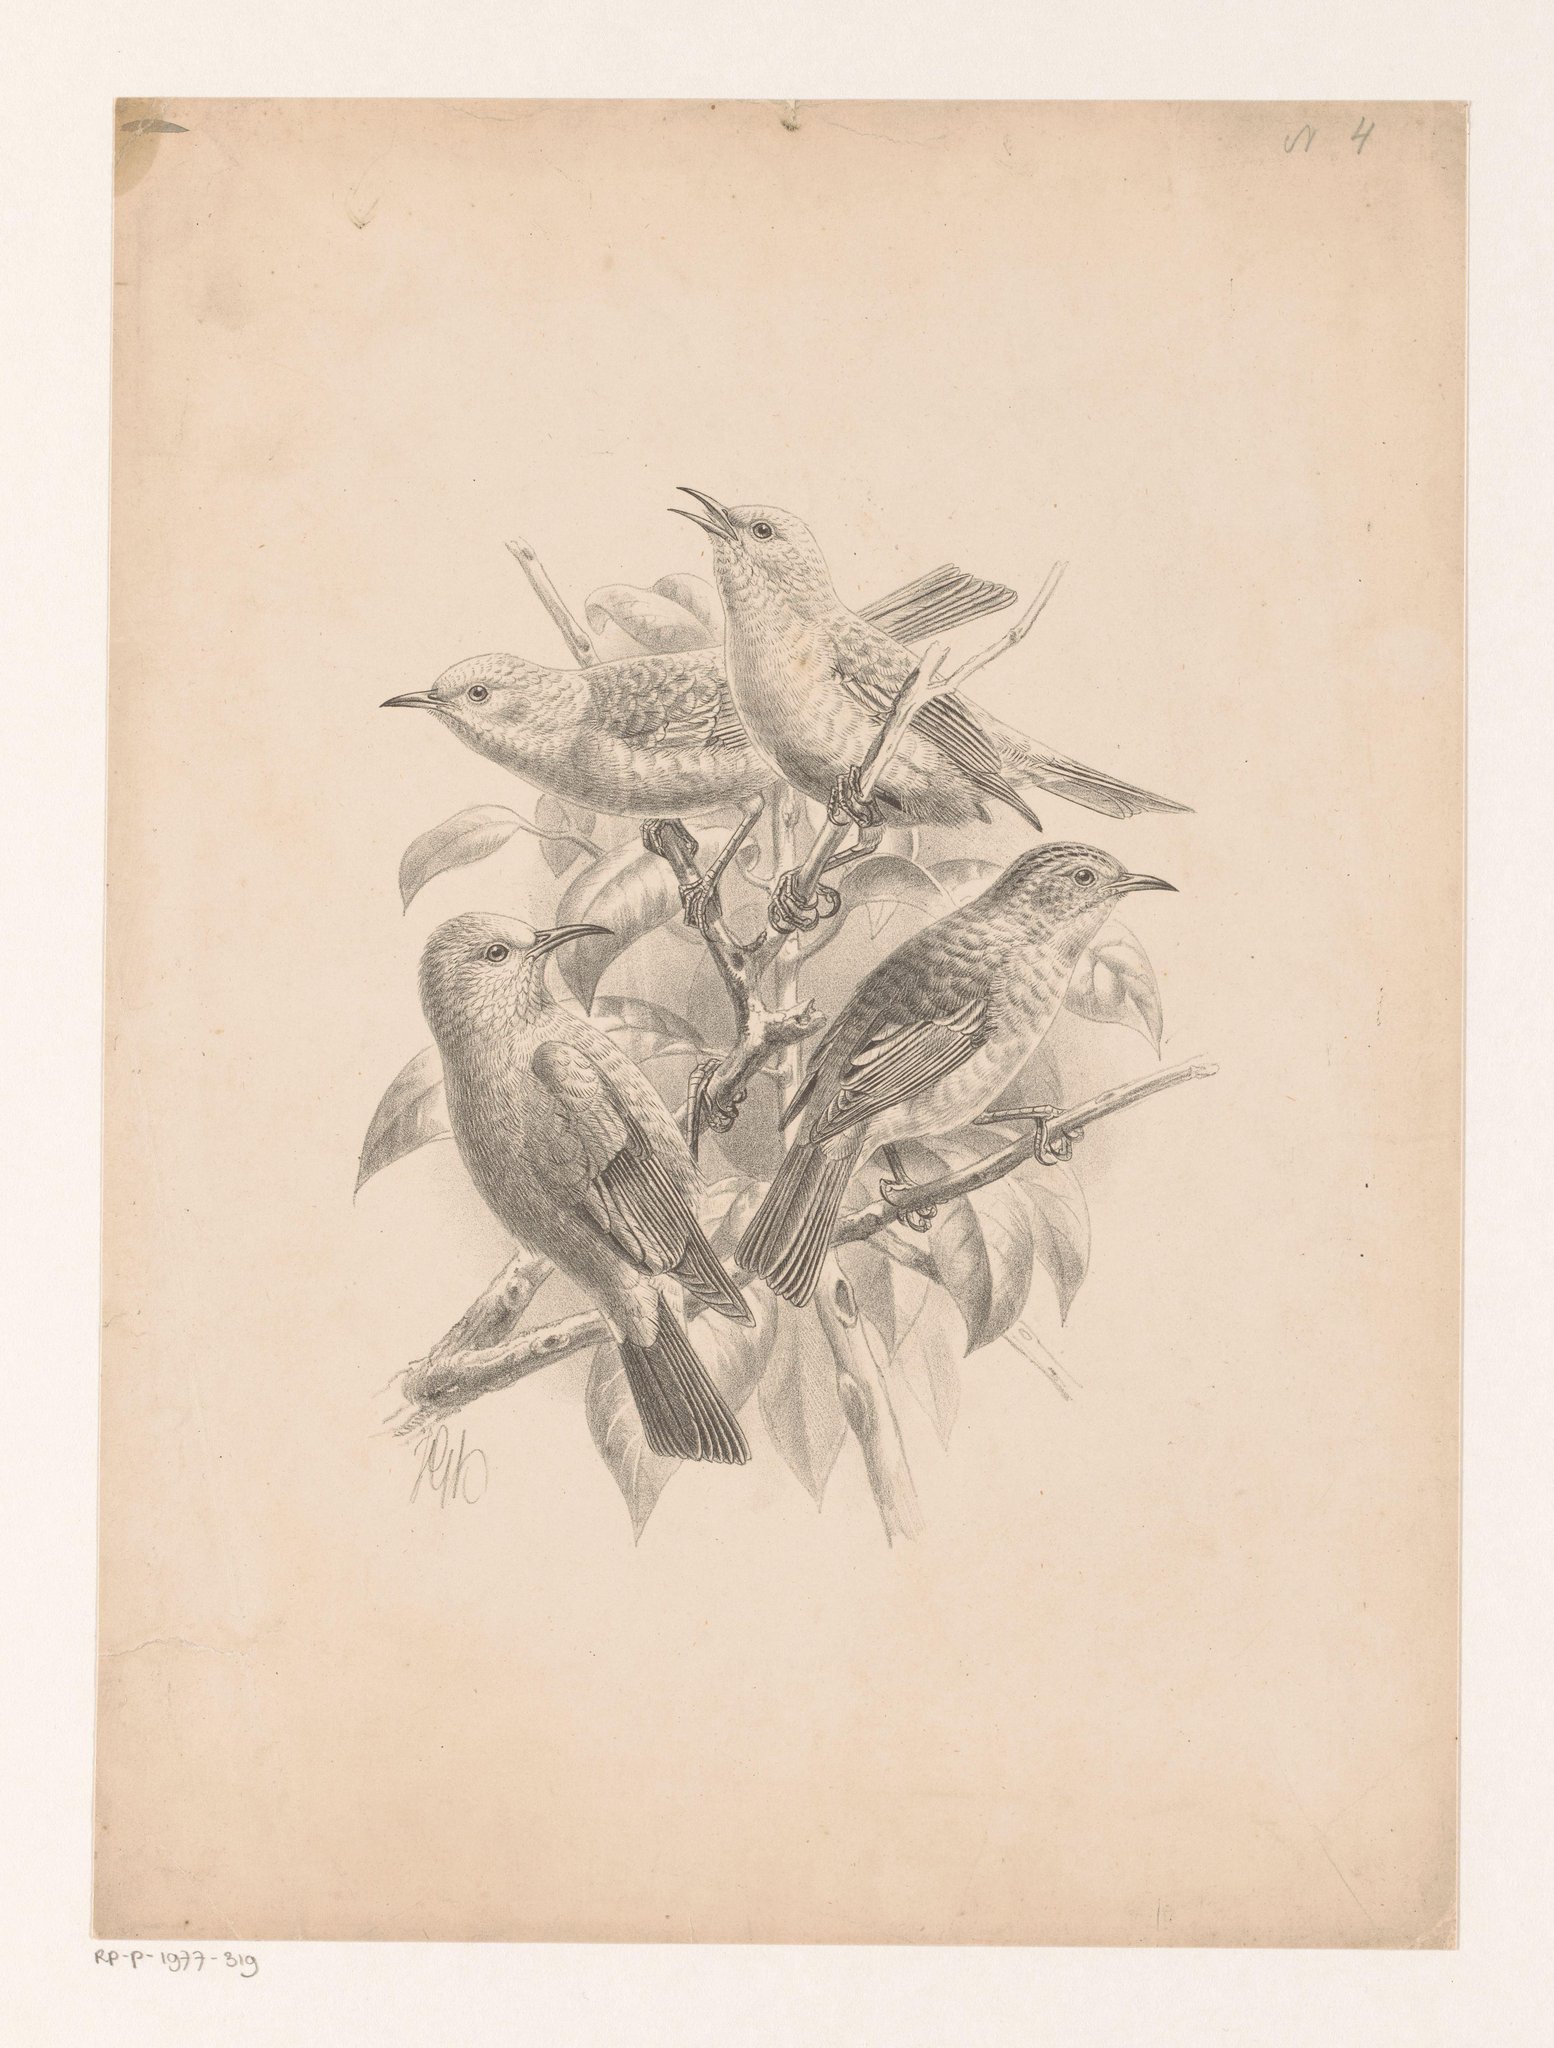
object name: print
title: Vier vogels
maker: johannes gerardus keulemans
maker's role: print maker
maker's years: 1842-1912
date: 1852-1912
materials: paper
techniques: lithograph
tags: trees (+ branch, stick), birds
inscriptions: collector's mark: Lugt 2228